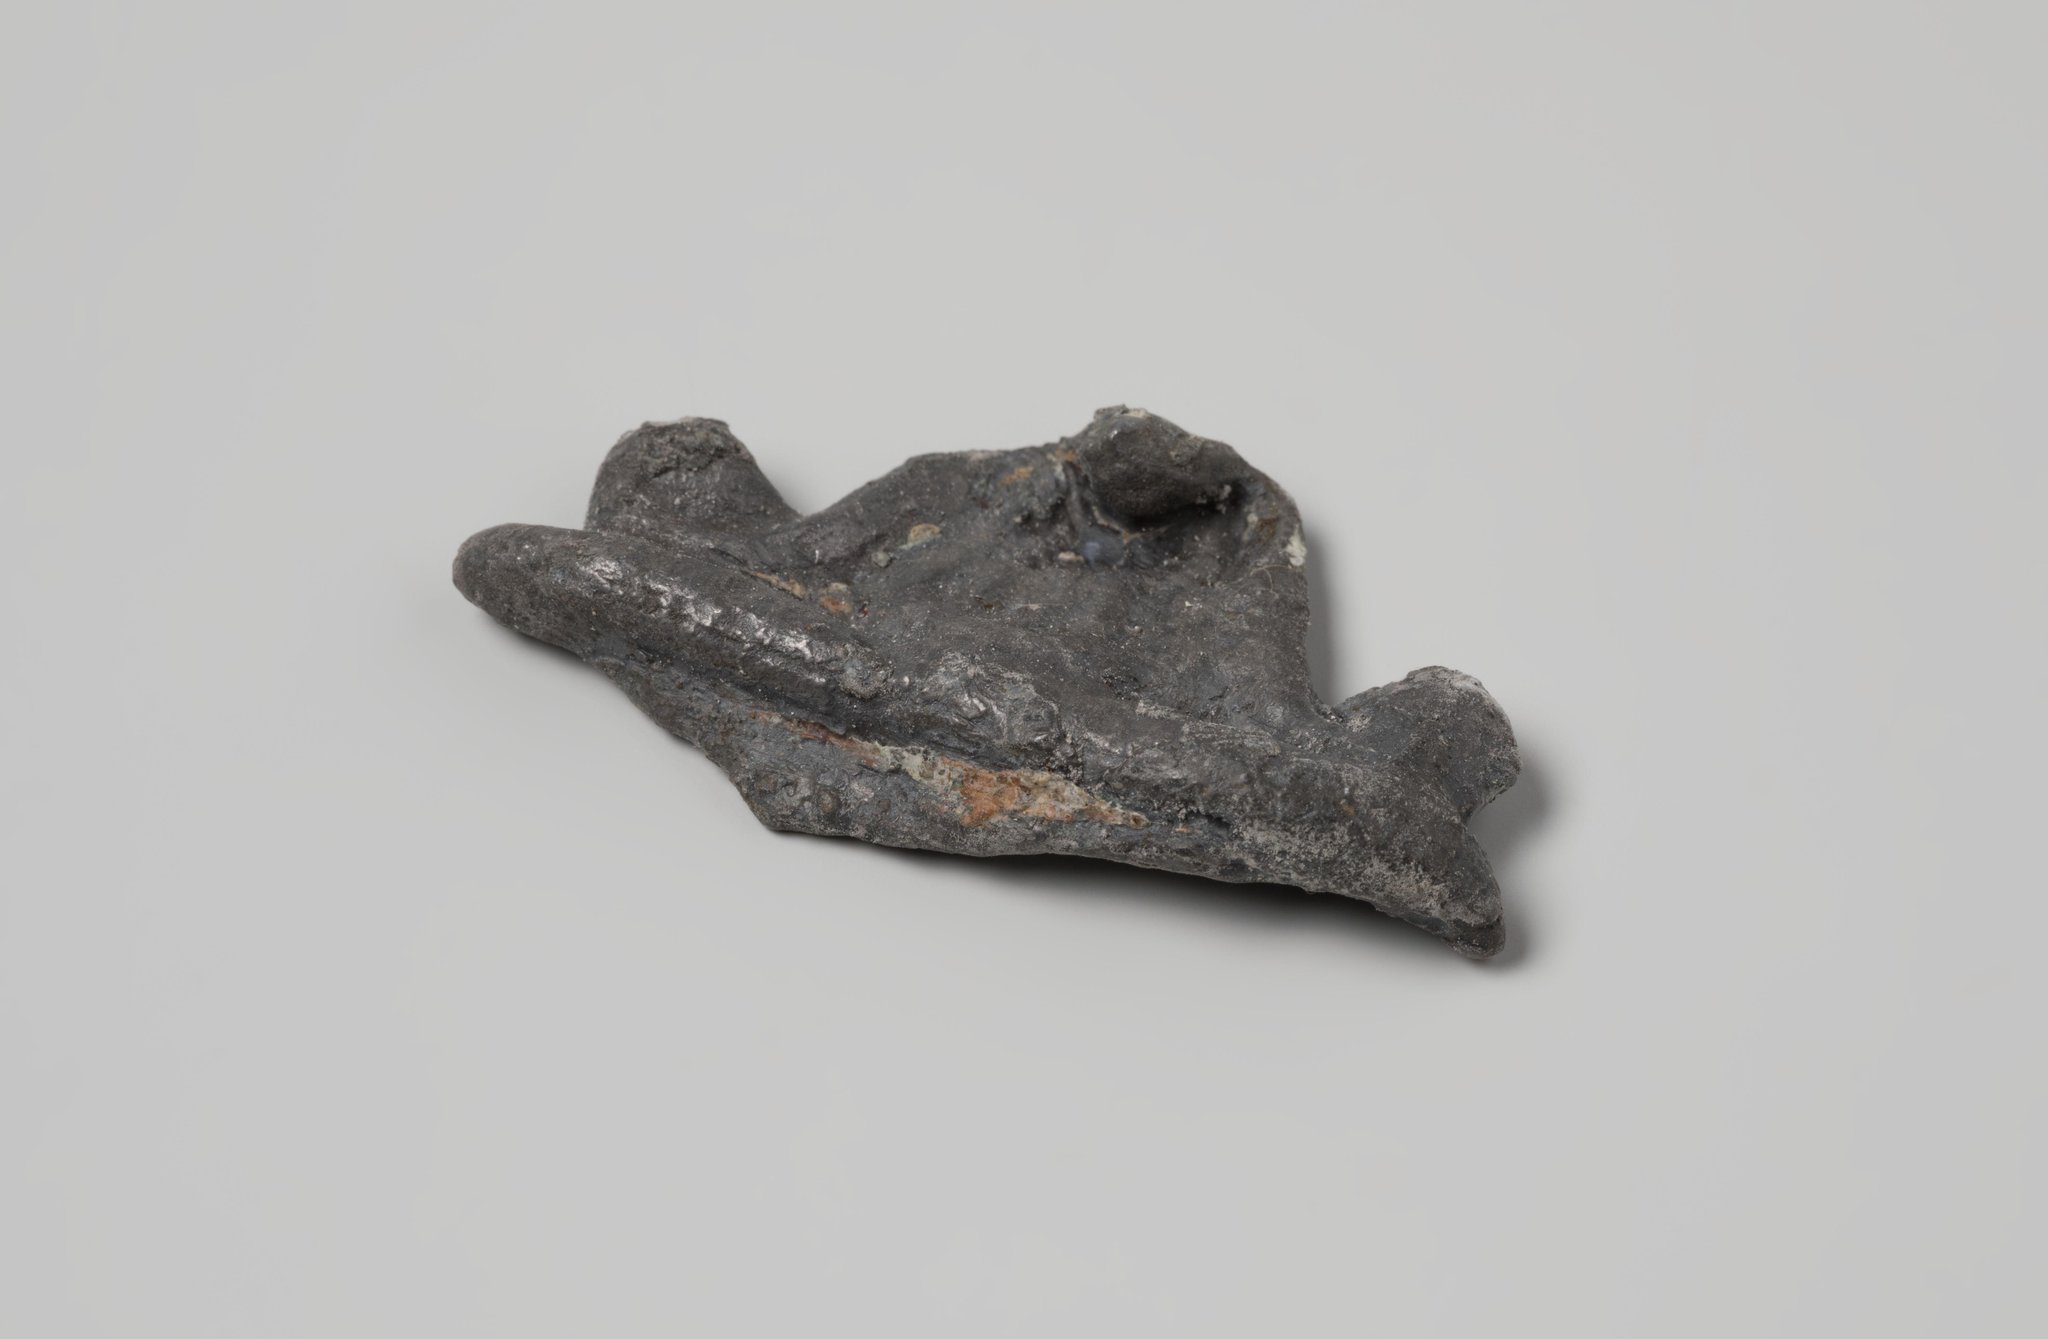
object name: beslag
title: Decoratief beslag uit het wrak van de Oost-Indiëvaarder Hollandia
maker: Anonymous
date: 1700-1743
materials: lead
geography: netherlands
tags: verenigde oostindische compagnie, hollandia (schip), annet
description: Fitting, decorative fitting or fragment; fragm of straight lower rim, scrolling cartouche with harp motif, flat rear side, eroded, squashed.